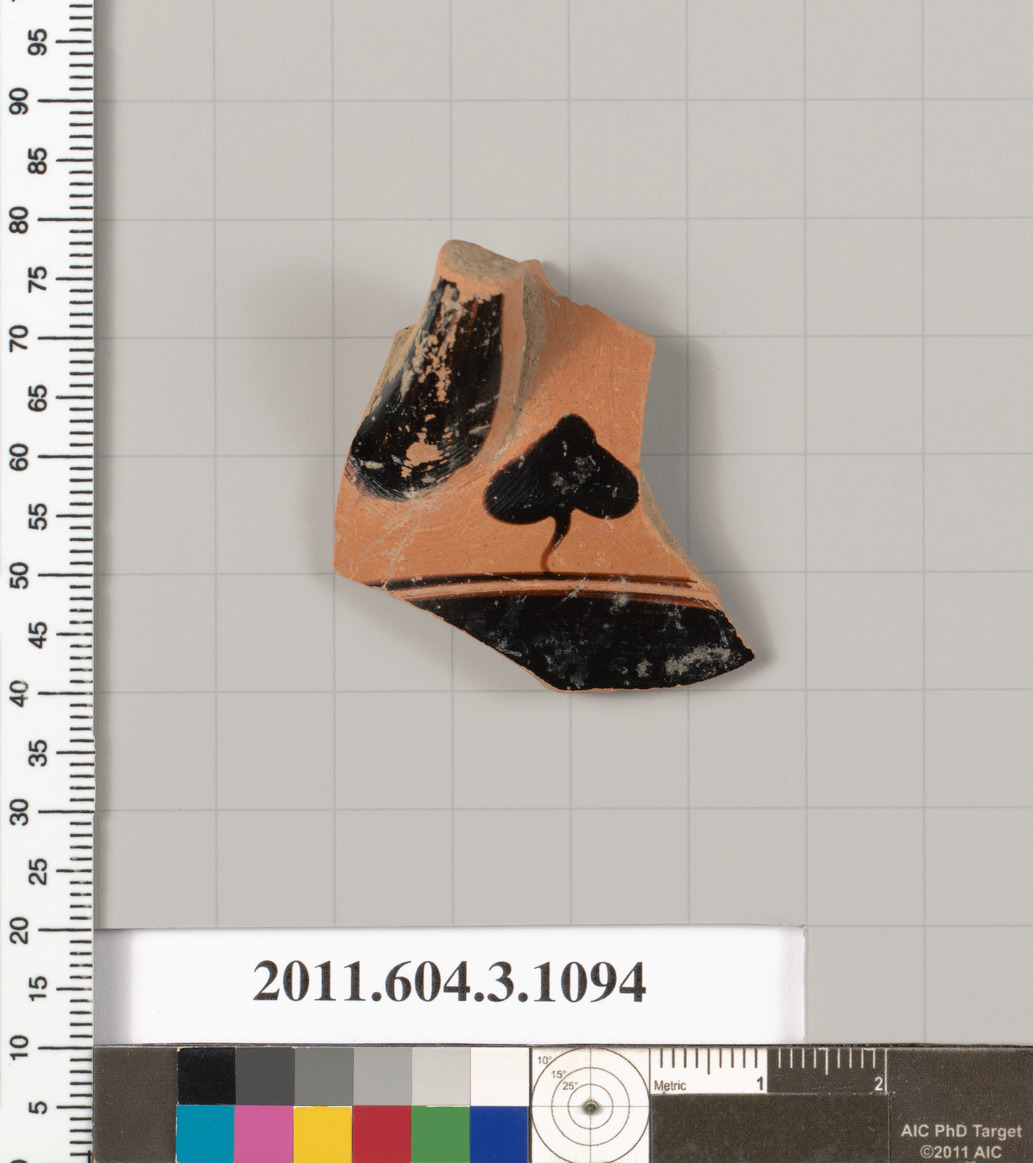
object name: mastoid fragment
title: Terracotta fragment of a mastoid (drinking cup with narrow base)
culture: greek, attic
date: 534-468 BCE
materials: terracotta